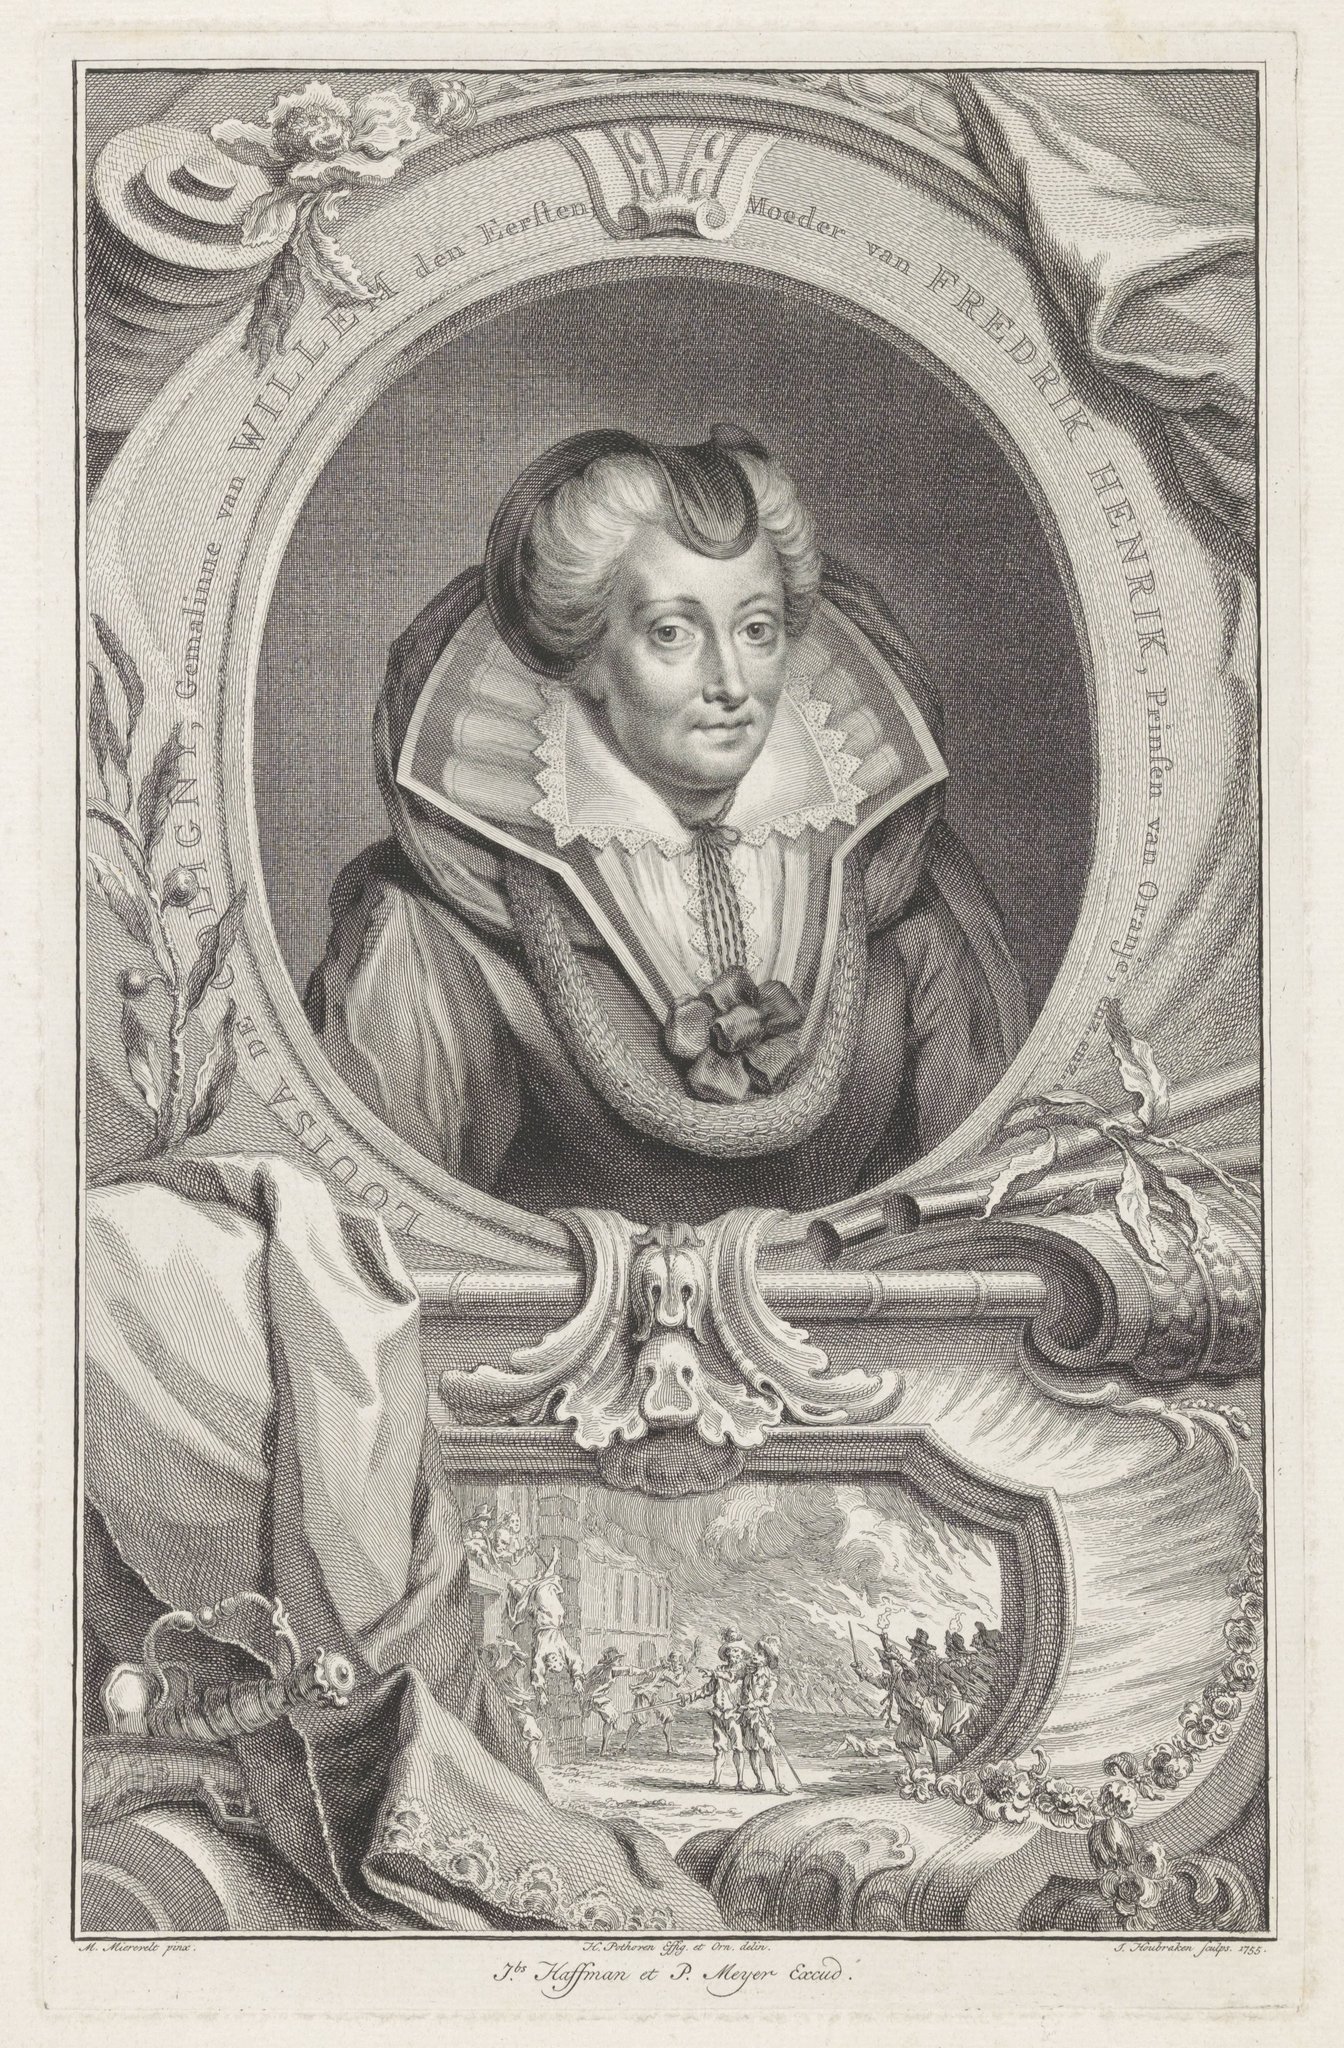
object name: print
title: Portret van Louise de Coligny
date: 1755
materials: paper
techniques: engraving, etching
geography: amsterdam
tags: louise de coligny, neck-gear: collar (+ women's clothes)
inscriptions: date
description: Portret van Louise in een ovaal met randschrift. Rondom ligt een aantal allegorische objecten. Op het reliëf een historische voorstelling.